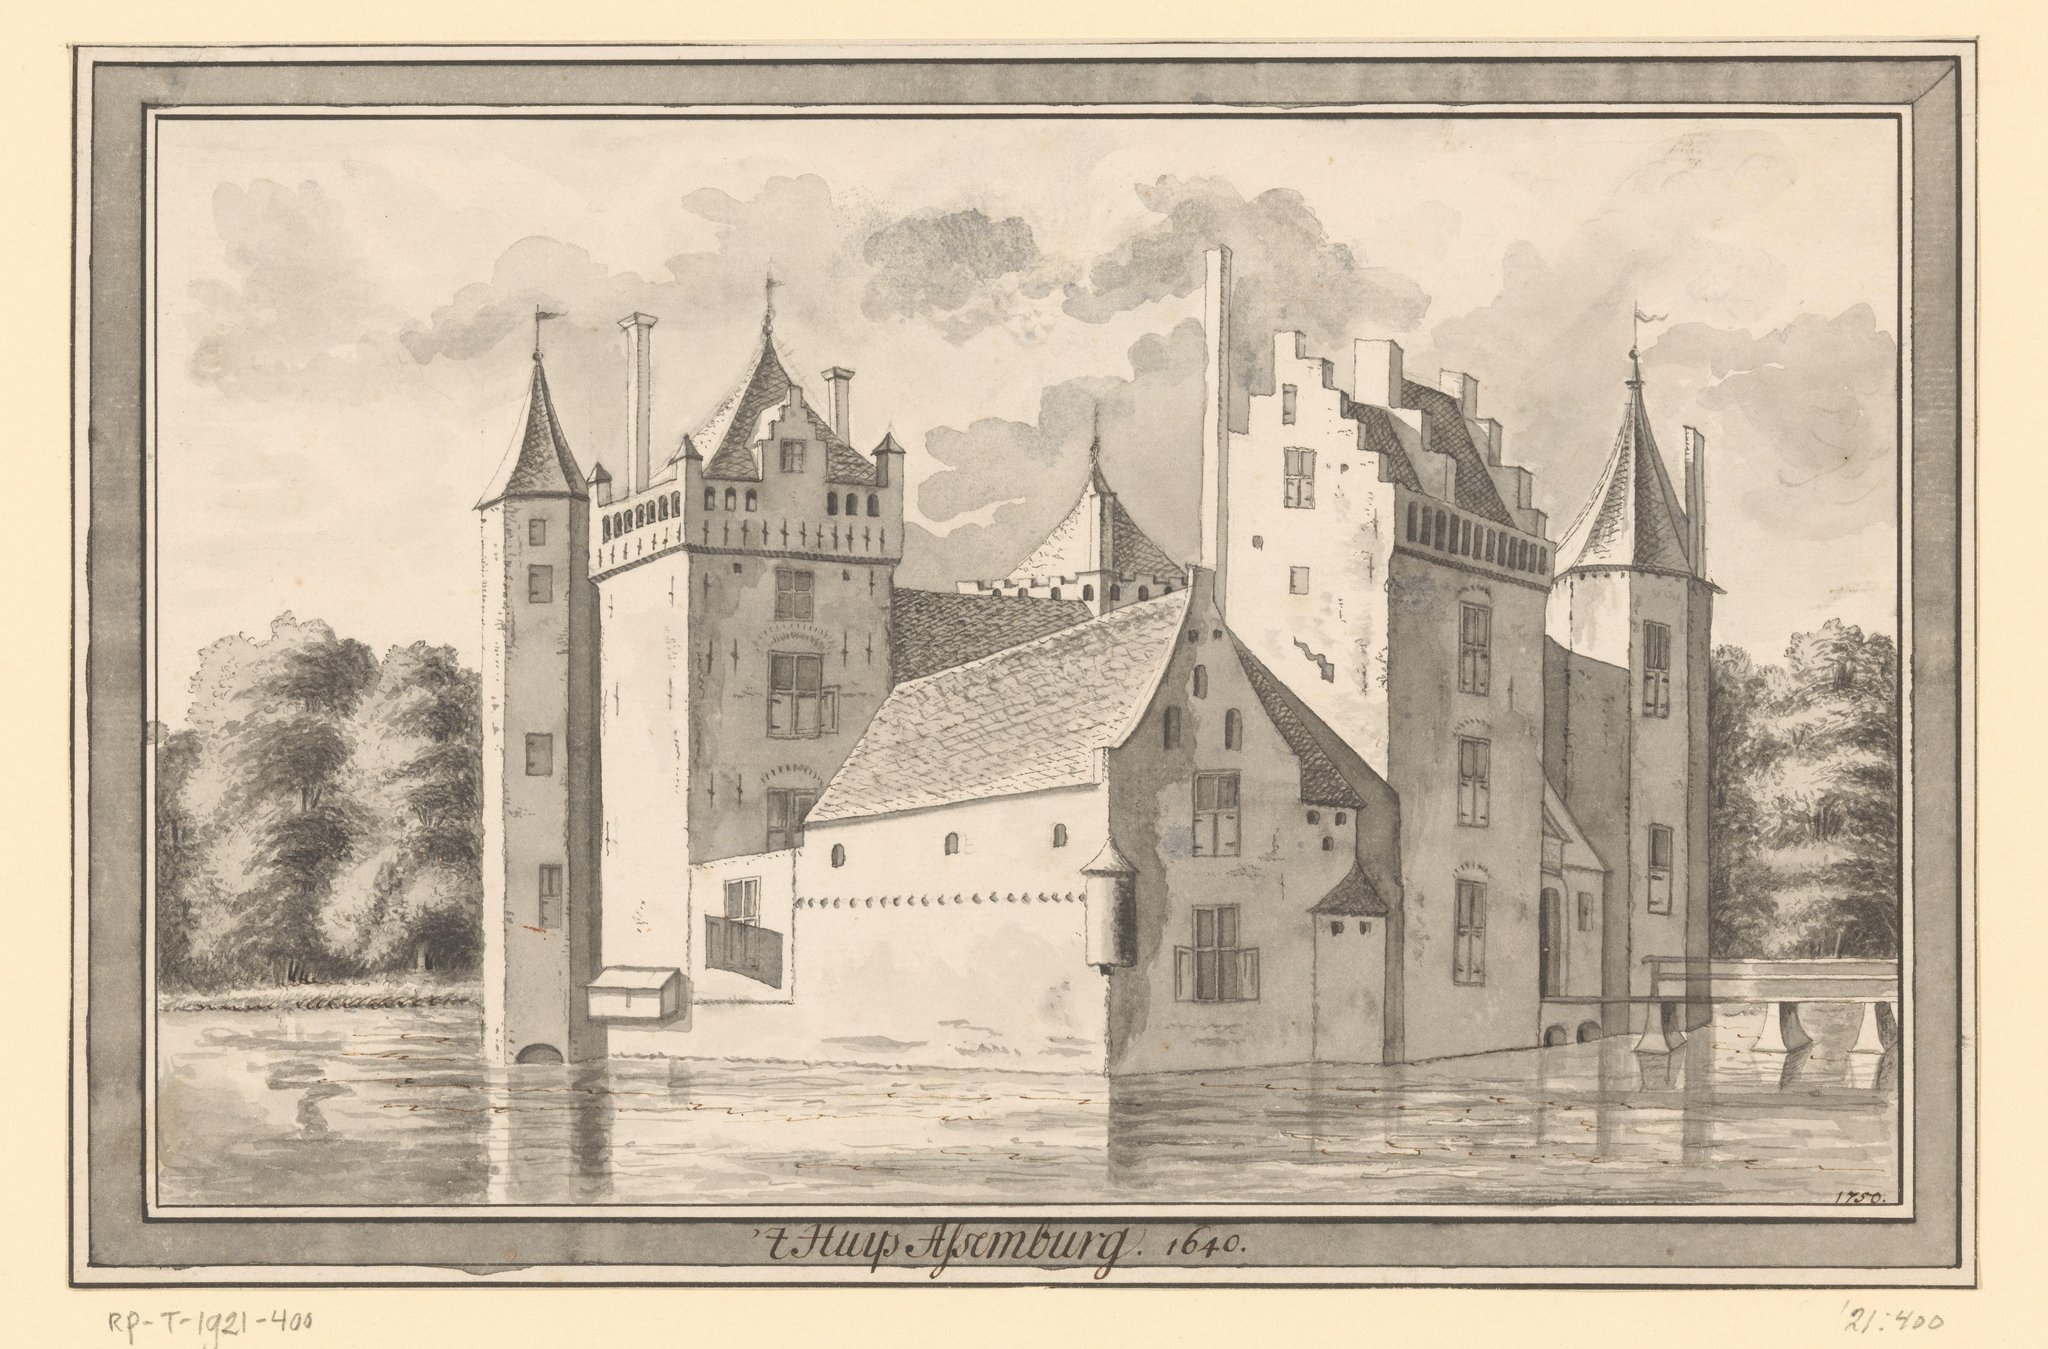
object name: drawing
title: 't Huys Assemburg, 1640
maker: jacobus schijnvoet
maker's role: draughtsman, print maker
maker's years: 1685-1743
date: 1750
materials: ink, paper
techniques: brush, pen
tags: castle, canal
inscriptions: inscription: ‘'t Huys Assemburg 1640’, collector's mark: Lugt 2233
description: Mogelijk naar een prent van Jacobus Schijnvoet, zie RP-P-1905-2229.